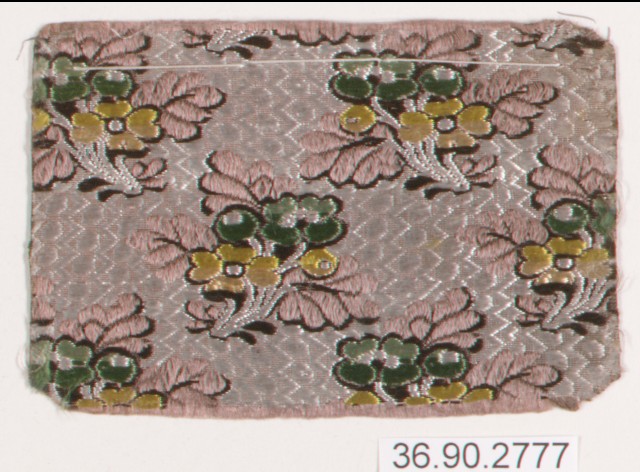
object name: piece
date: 1801-1900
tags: flowers